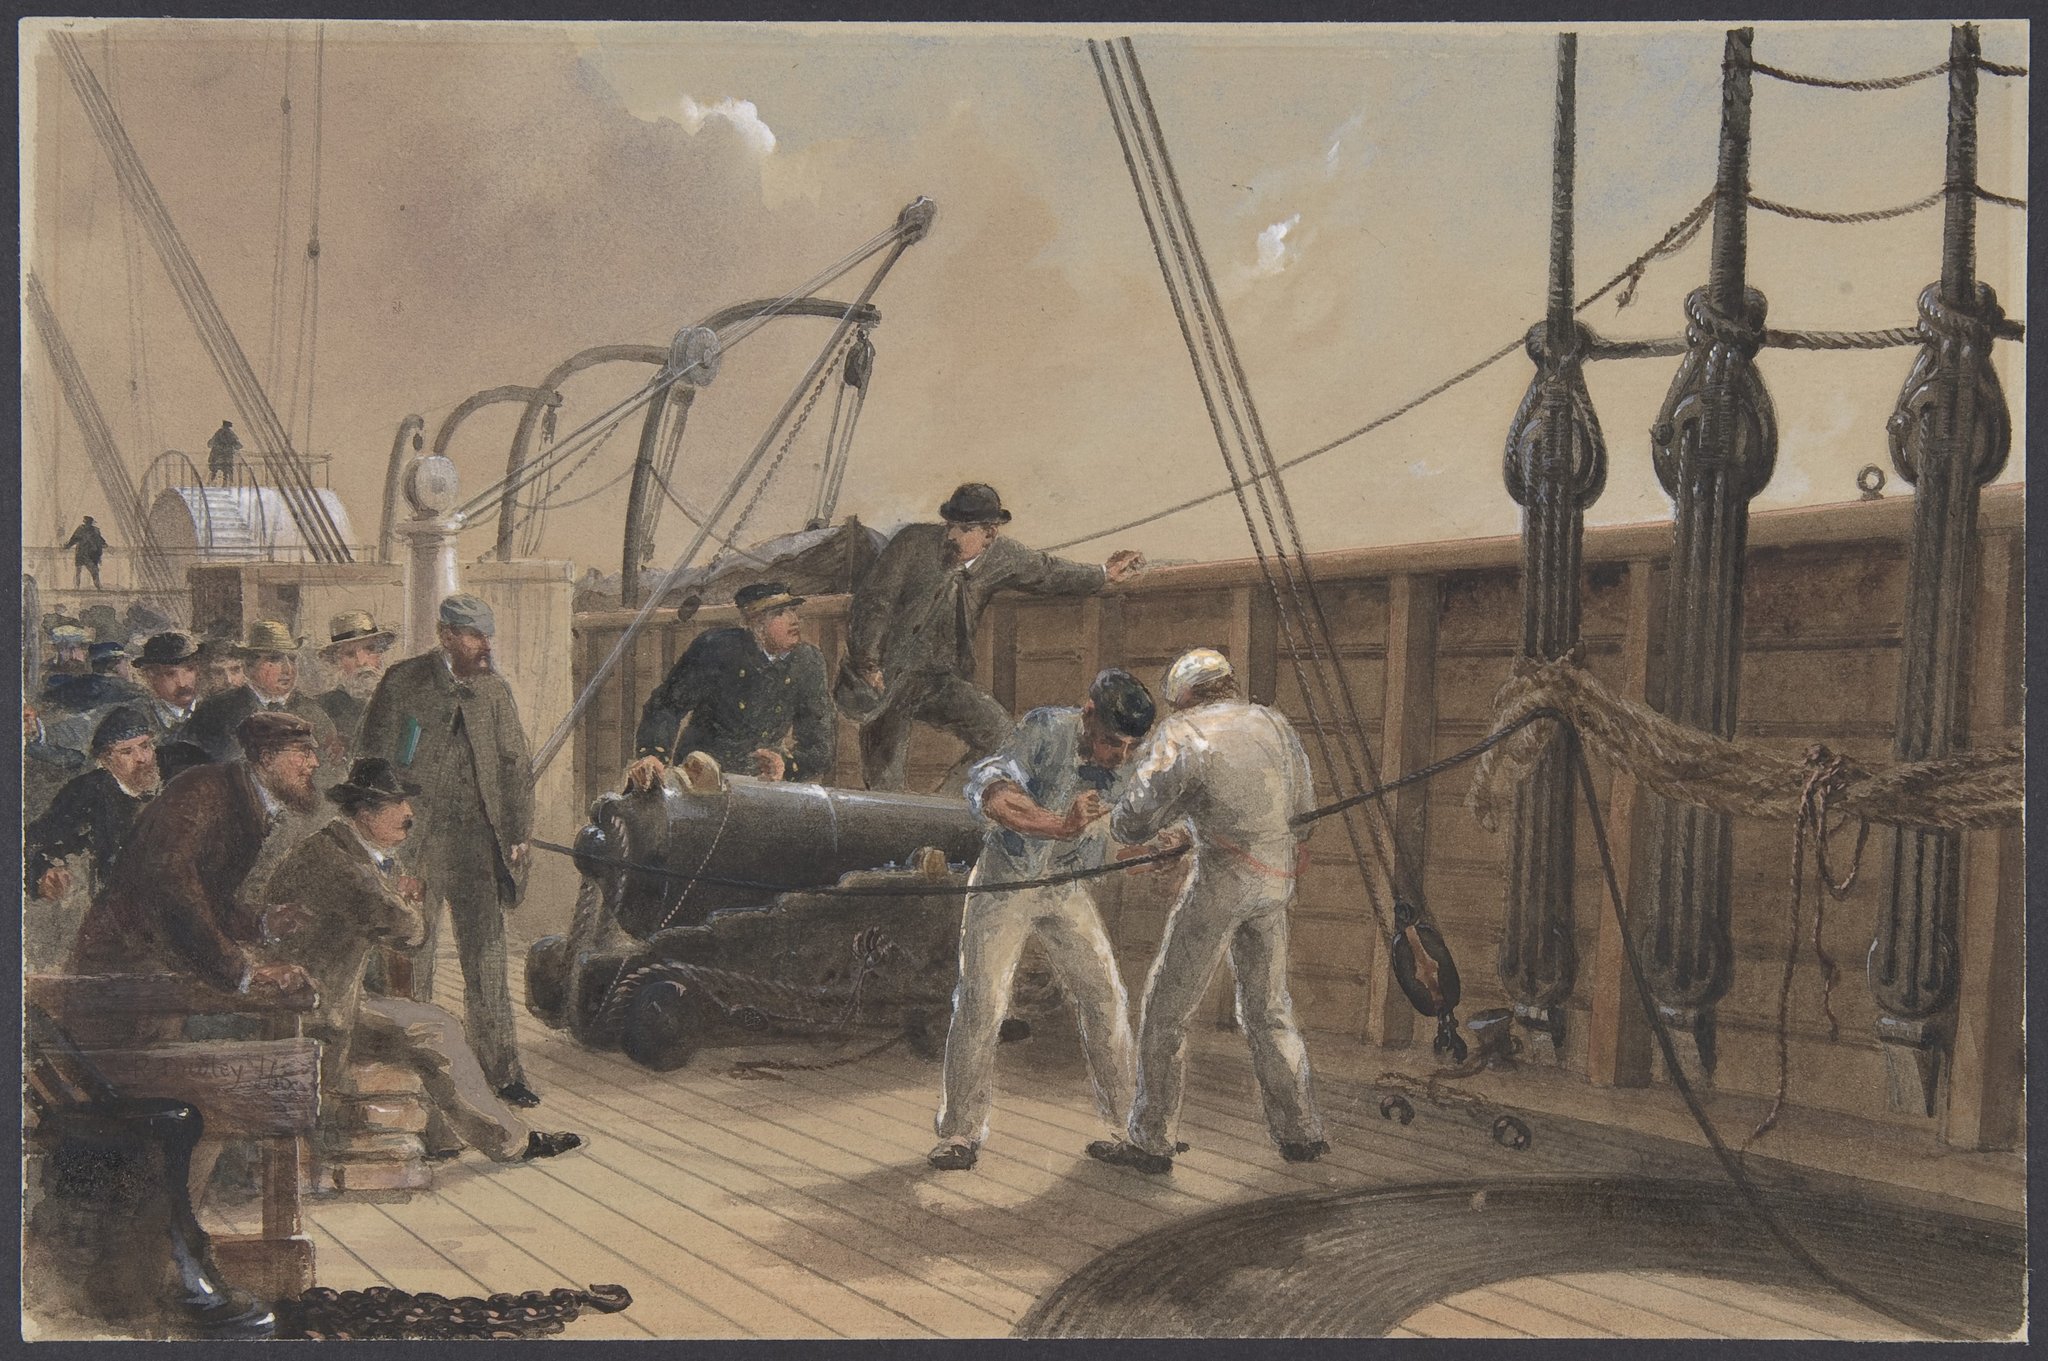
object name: drawing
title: Splicing the Cable (after the First Accident) on Board the Great Eastern, July 25th, 1865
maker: robert charles dudley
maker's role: artist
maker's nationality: british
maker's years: 1826-1909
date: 1865-1866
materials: gouache, graphite, watercolor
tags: cannons,men,working,transatlantic cable